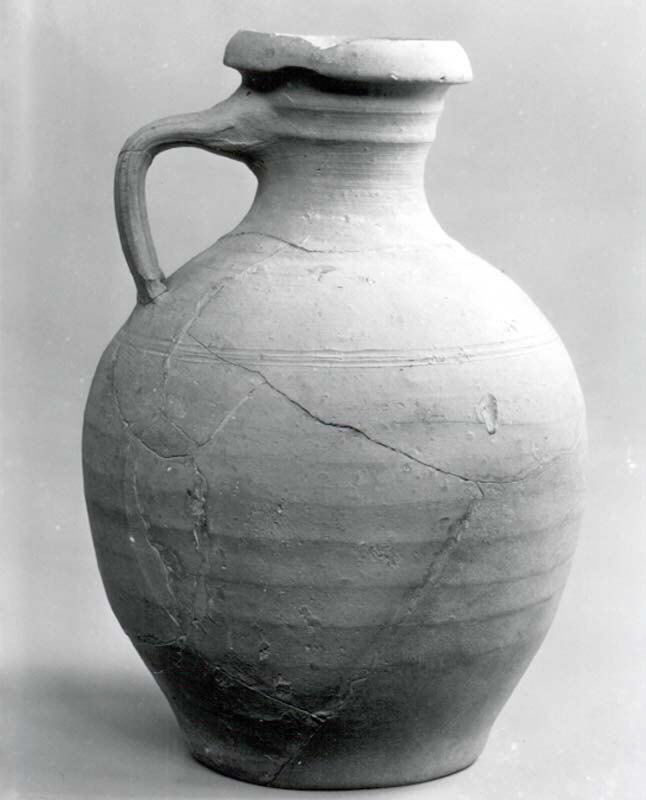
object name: jug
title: Jug with handle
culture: sasanian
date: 201-700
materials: ceramic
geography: iran